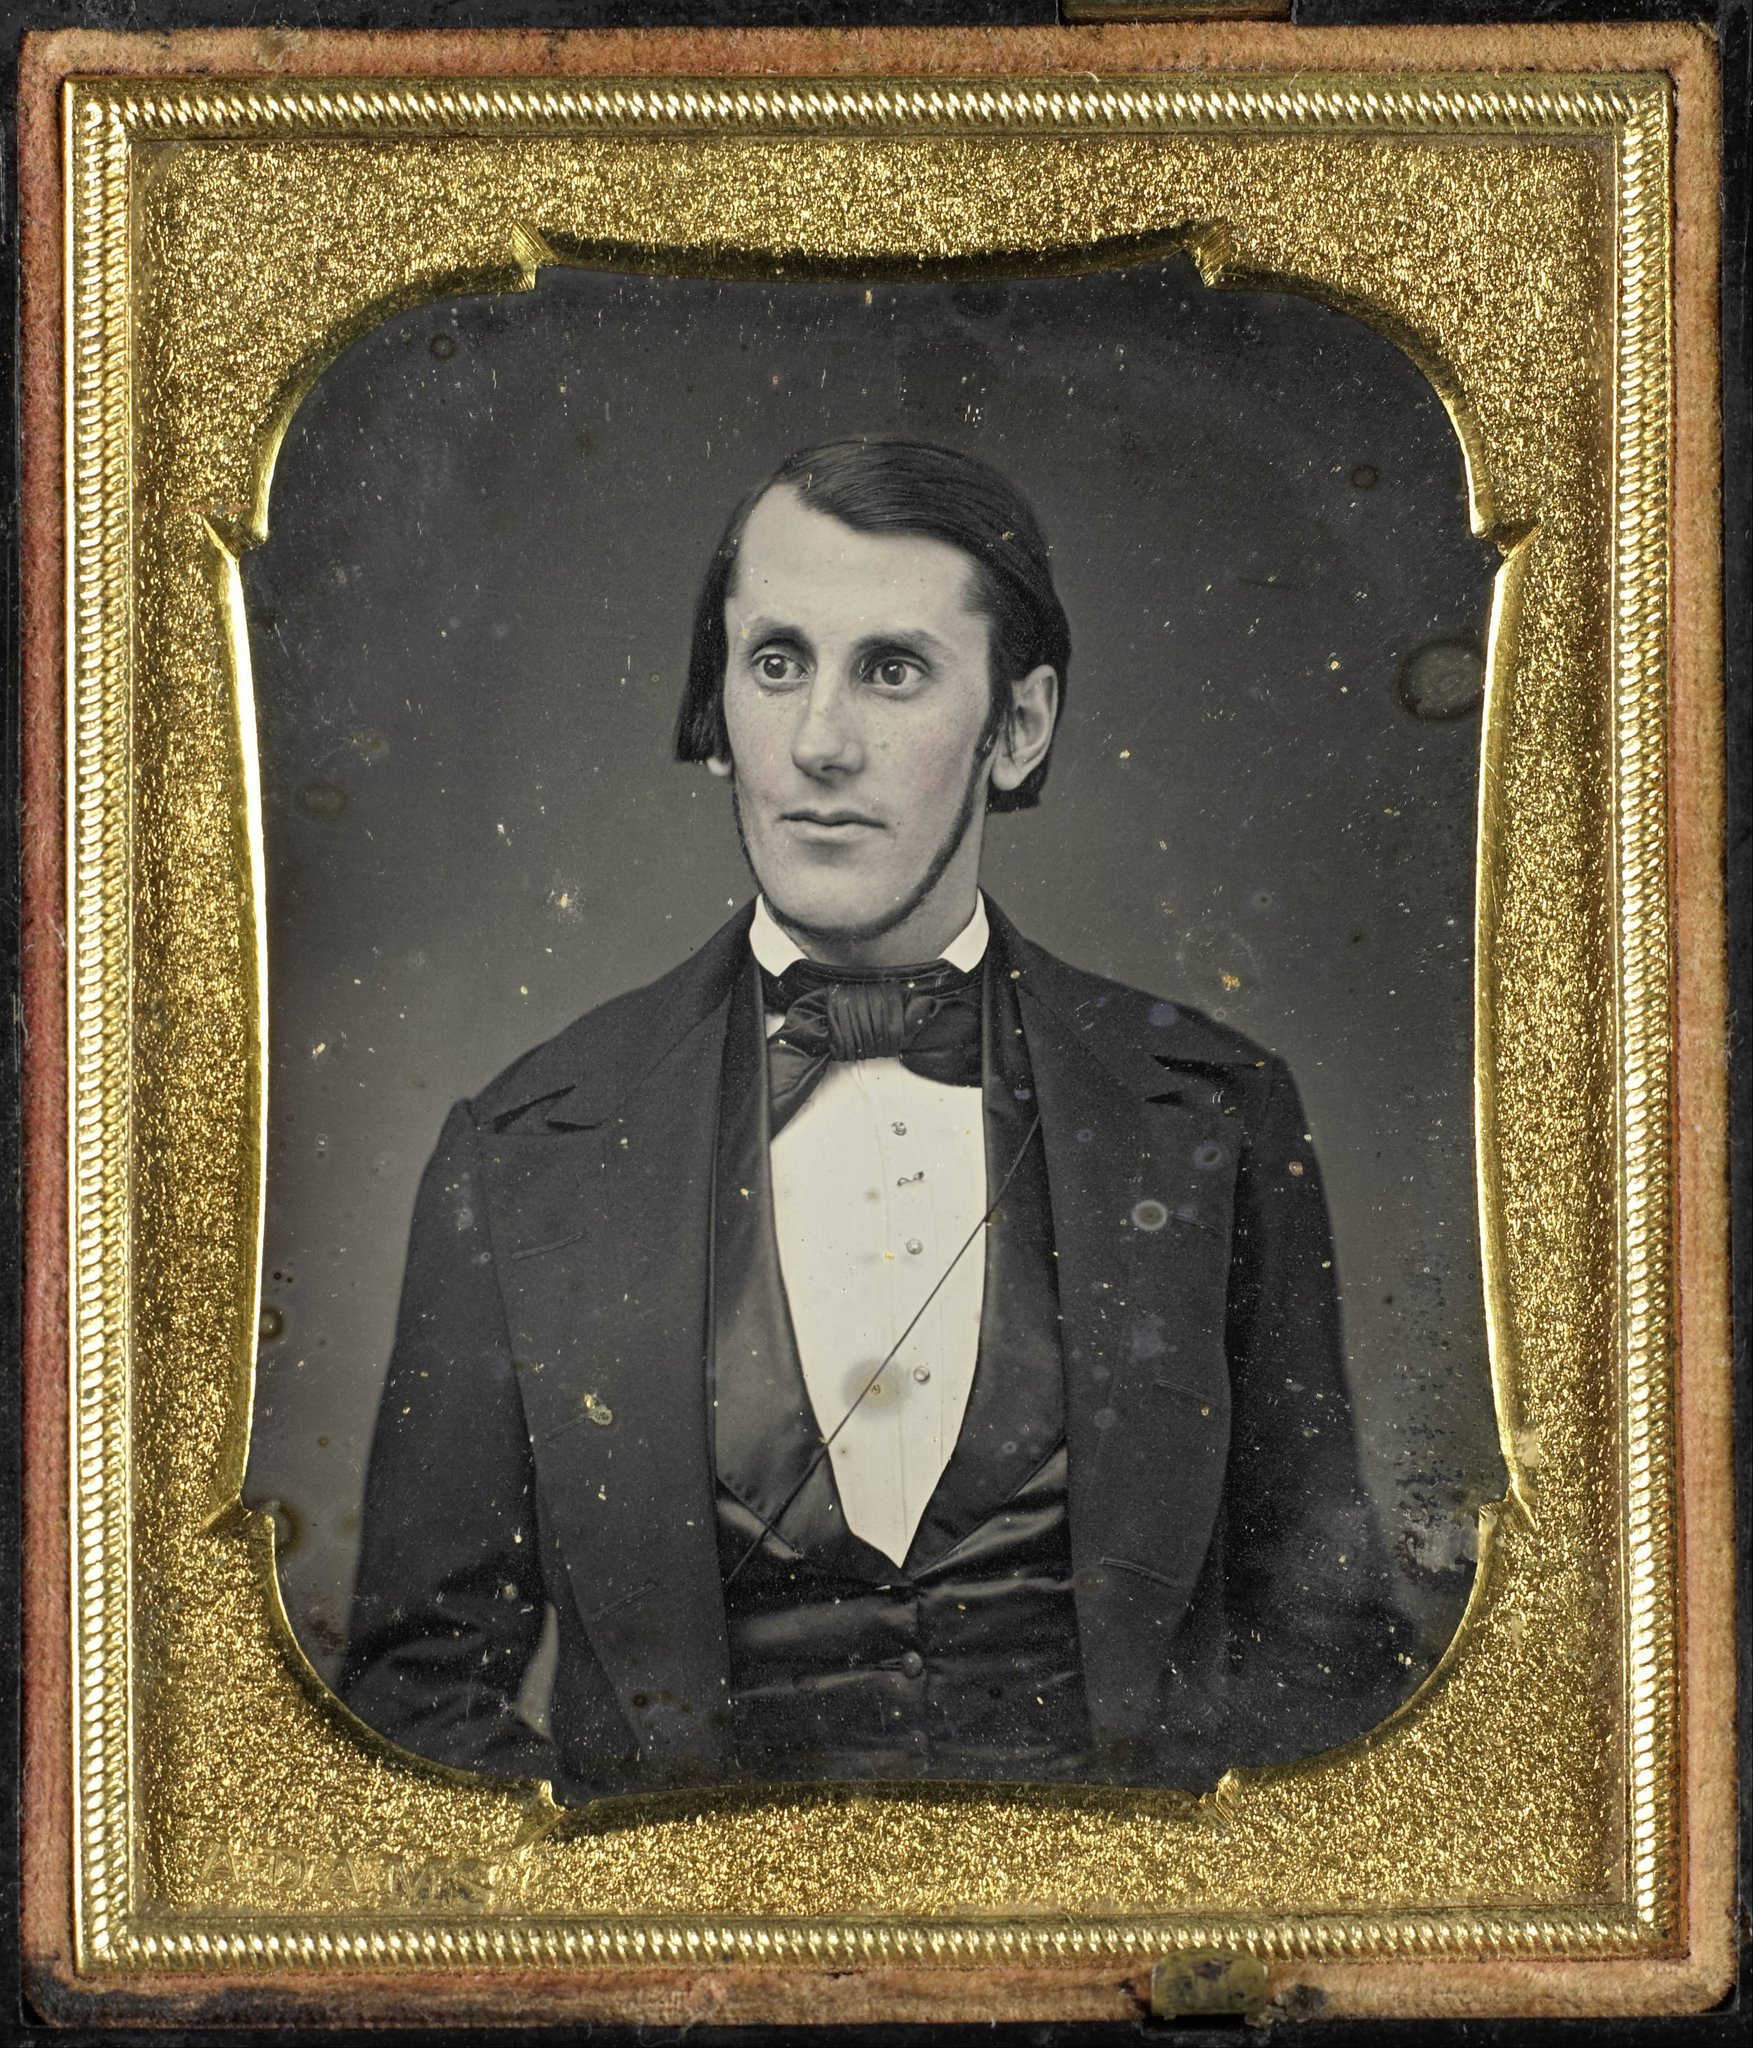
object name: photograph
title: Portret van een onbekende man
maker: walton adams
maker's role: fotograaf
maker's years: 1842-1934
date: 1840-1860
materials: copper, glass, plastic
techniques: daguerreotype, hand coloring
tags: adult man, historical persons